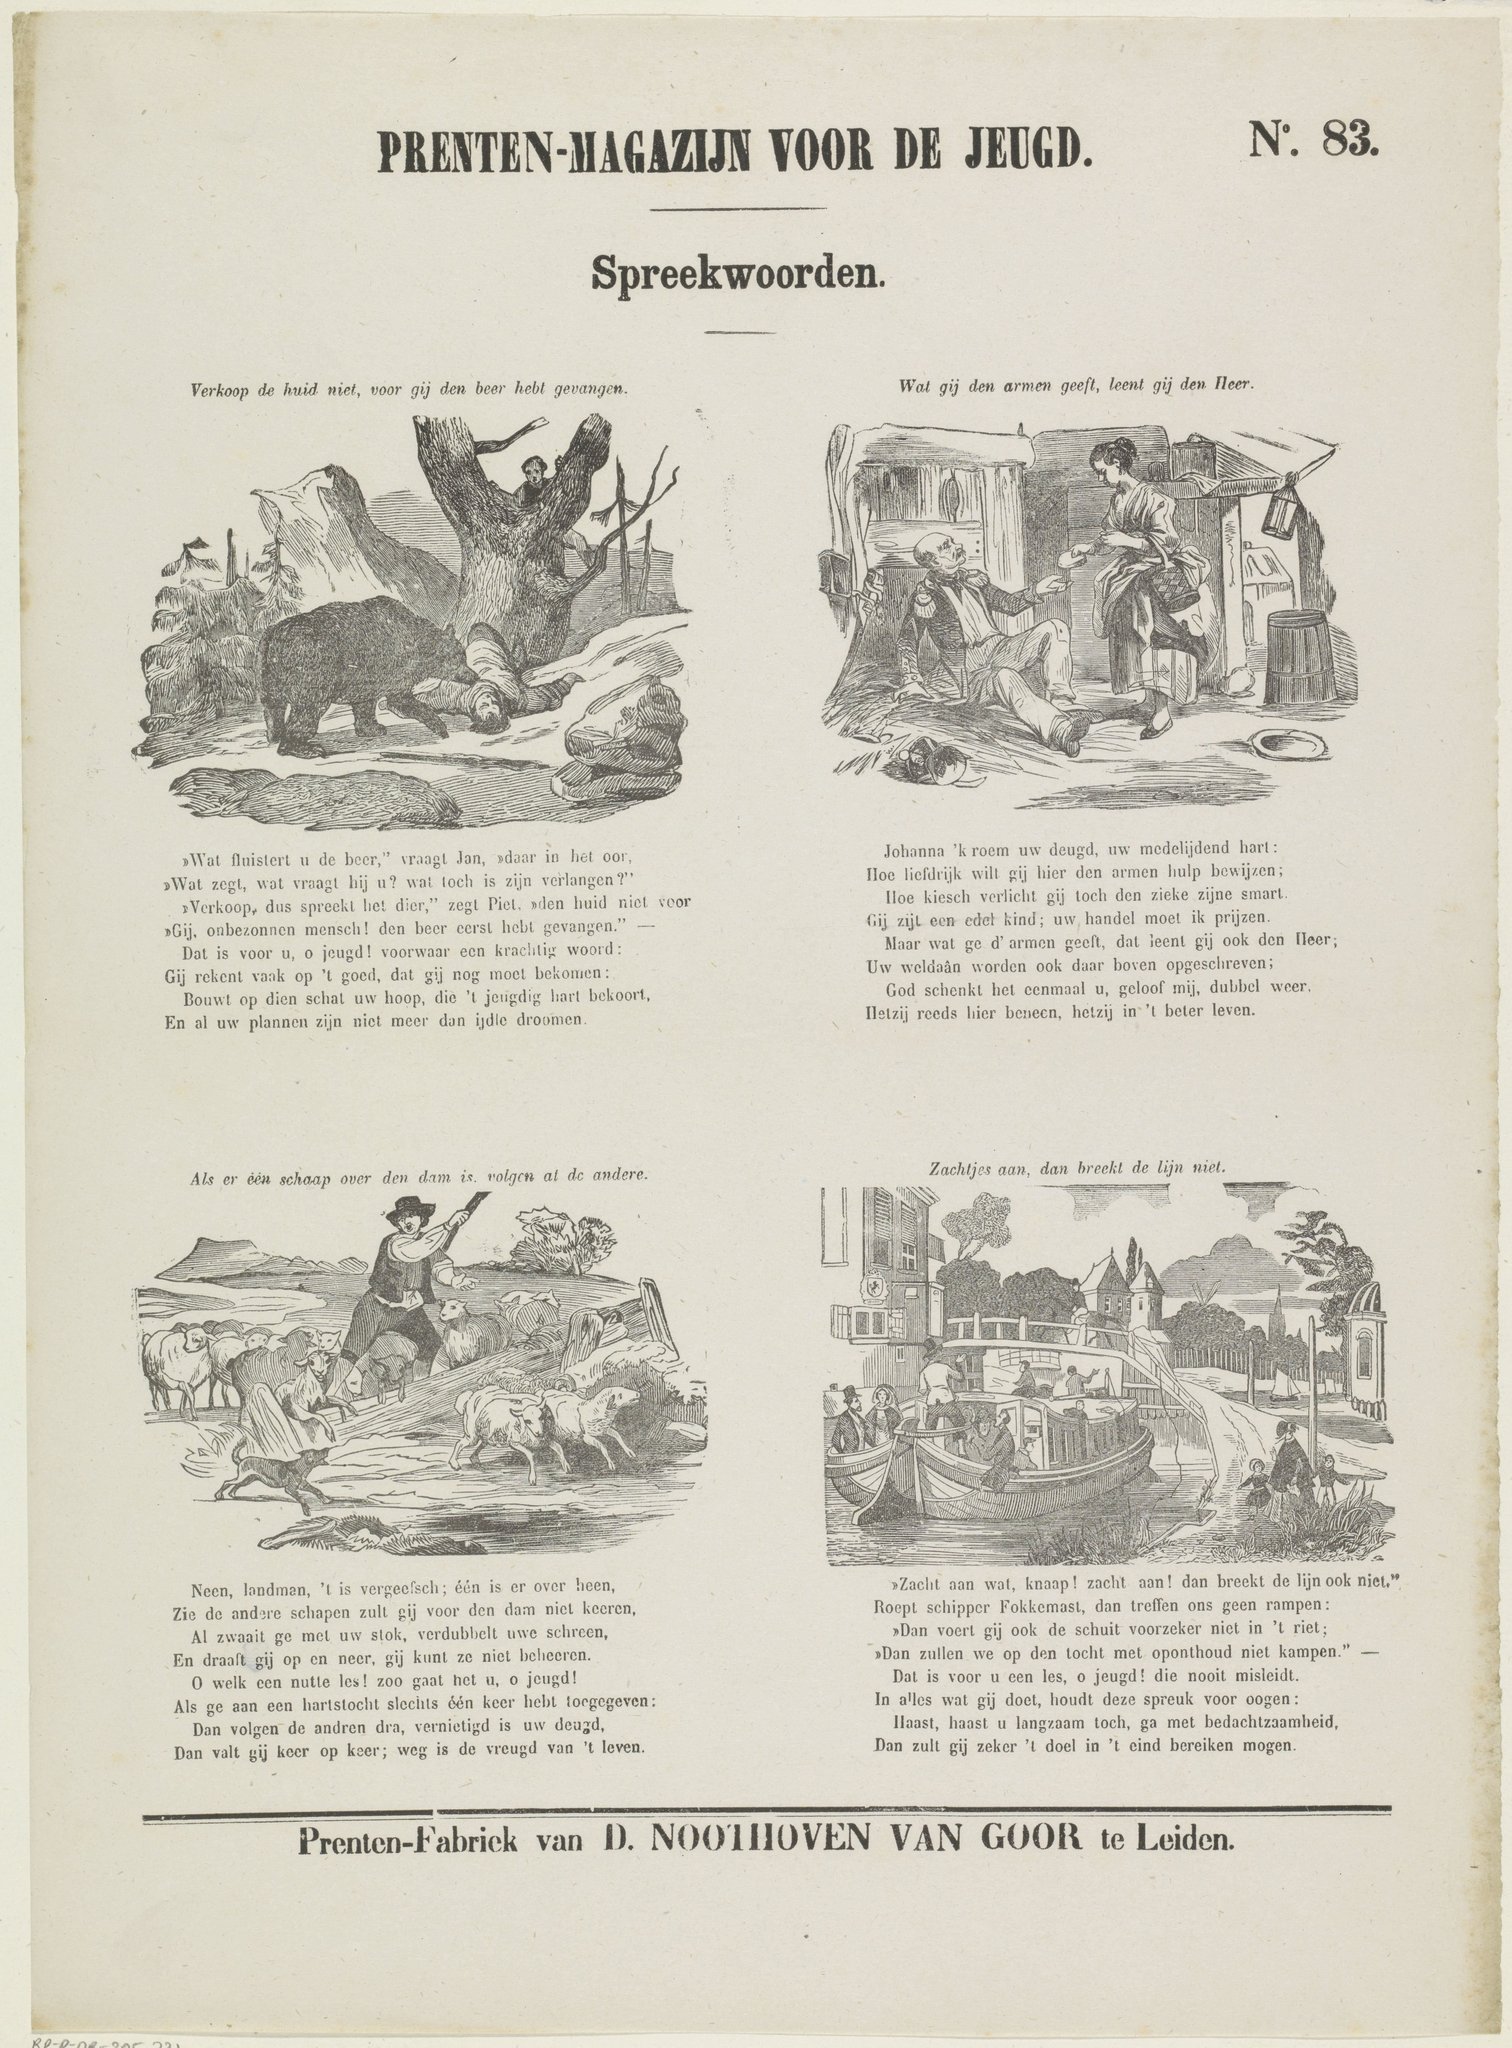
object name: popular print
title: Spreekwoorden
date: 1850-1881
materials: paper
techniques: letterpress printing, engraving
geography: netherlands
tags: proverbs, sayings, etc.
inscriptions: collector's mark: Lugt 2760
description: Blad met 4 verbeeldingen van spreekwoorden. Boven elke voorstelling een titel en onder elke voorstelling een achtregelig vers. Genummerd rechtsboven: No. 83.